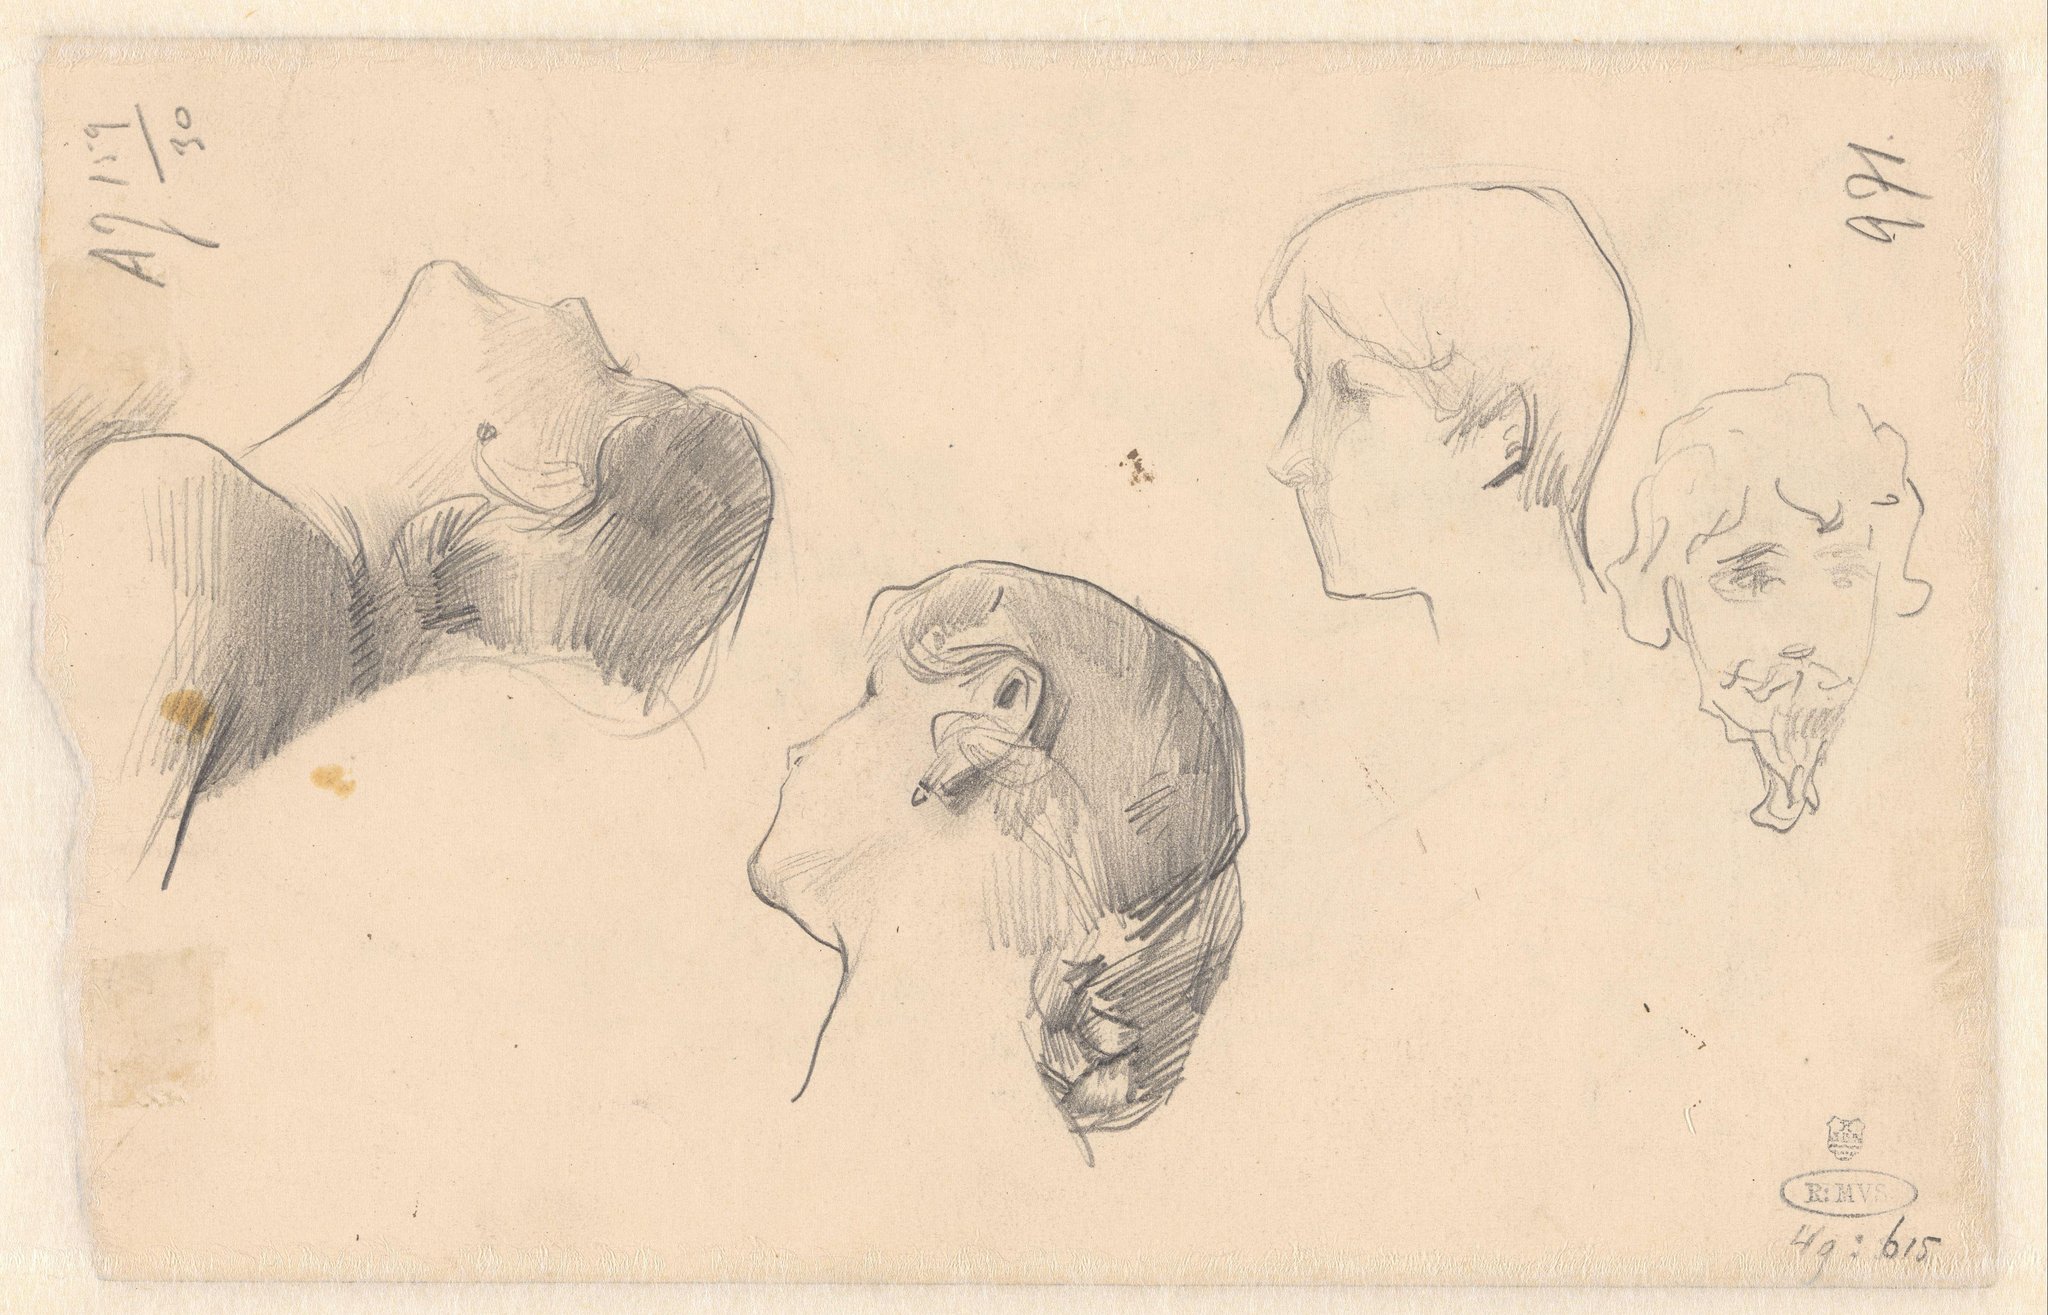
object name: drawing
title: Studieblad met vier hoofden van mannen en vrouwen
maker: nicolaas van der waay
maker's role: draughtsman, painter, print maker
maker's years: 1855-1936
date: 1865-1936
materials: paper, pencil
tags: head (human)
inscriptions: annotation: ‘AJ 159/30’, number: ‘971’, collector's mark: Lugt 2760, collector's mark: Lugt 2228